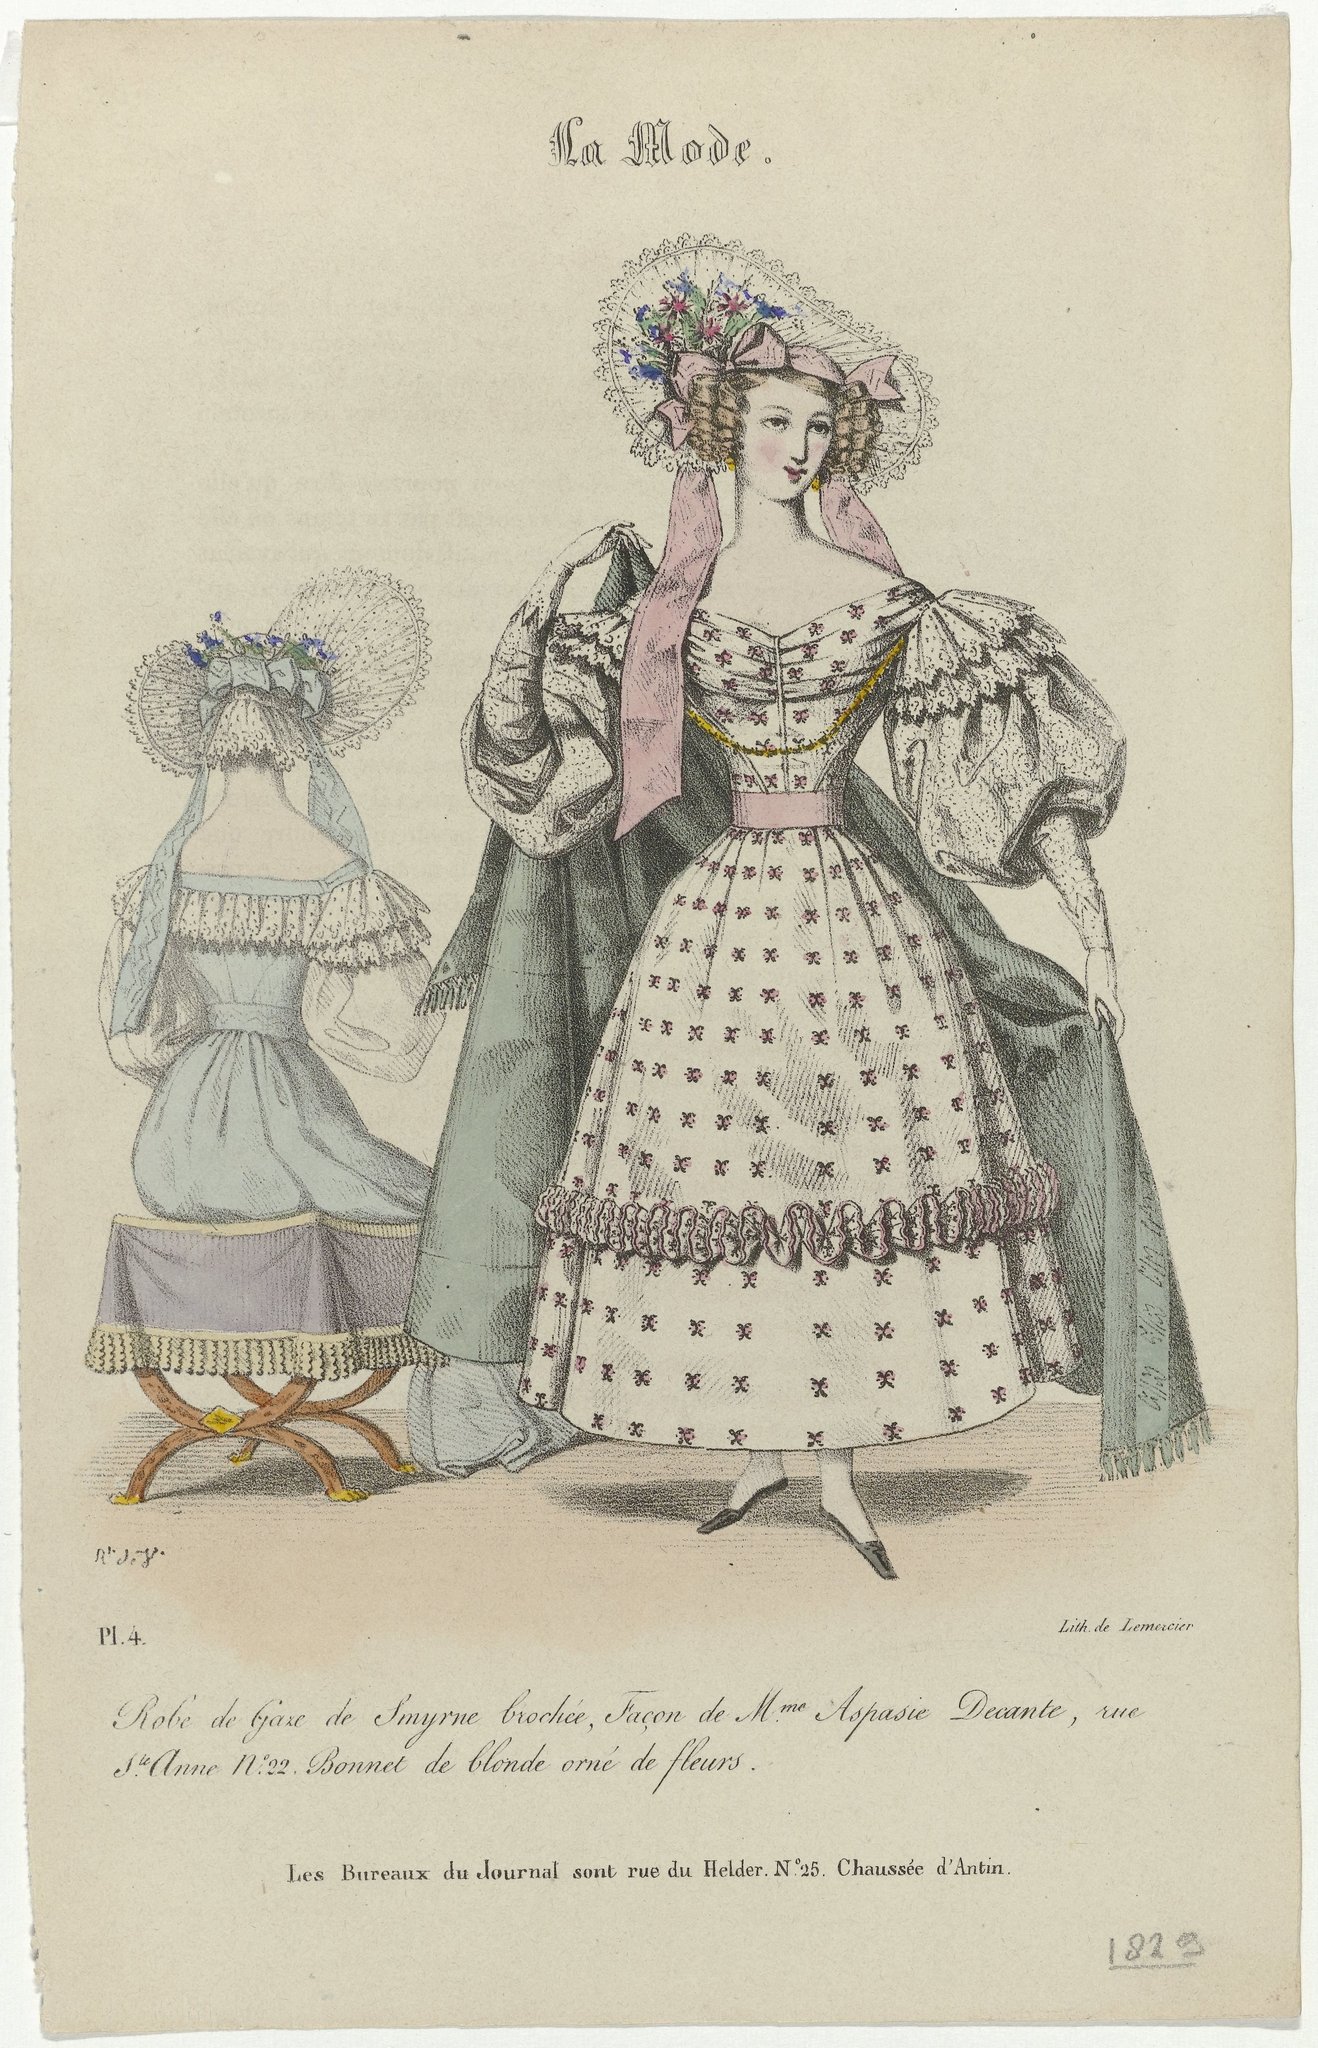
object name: fashion print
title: La Mode, 1829, Pl. 4 : Robe de Gaze de Smyrne broché (...)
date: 1829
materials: paper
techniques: engraving, hand coloring, lithograph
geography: paris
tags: flowers, ear-rings (+ women's clothes), clothing for the upper part of the body (shawl) (+ women's clothes), head-gear: cap (+ lace used for clothes), head-gear: cap (+ women's clothes), fashion plates, shoes, sandals (+ women's clothes), dress, gown (+ women's clothes), necklace (+ women's clothes)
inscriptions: caption: ‘Robe de Gaze de Smyrne brochée, Façon de Mme Aspasie Decante, rue Ste Anne No.22. Bonnet de blonde orné de fleurs.’, title: ‘La Mode.’, address: ‘Les Bureaux du Journal sont rue du Helder.No. 25. Chaussée d'Antin.’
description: Japon van gebrocheerd 'gaze de Smyrne', uitgevoerd op de manier van Aspasie Decante. Muts van Blonde (kloskant), versierd met bloemen. Verdere accessoires: oorbellen, collier (?), sjaal afgezet met franjes, platte schoenen met vierkante neuzen. Prent uit het modetijdschrift La Mode (1829-1855).